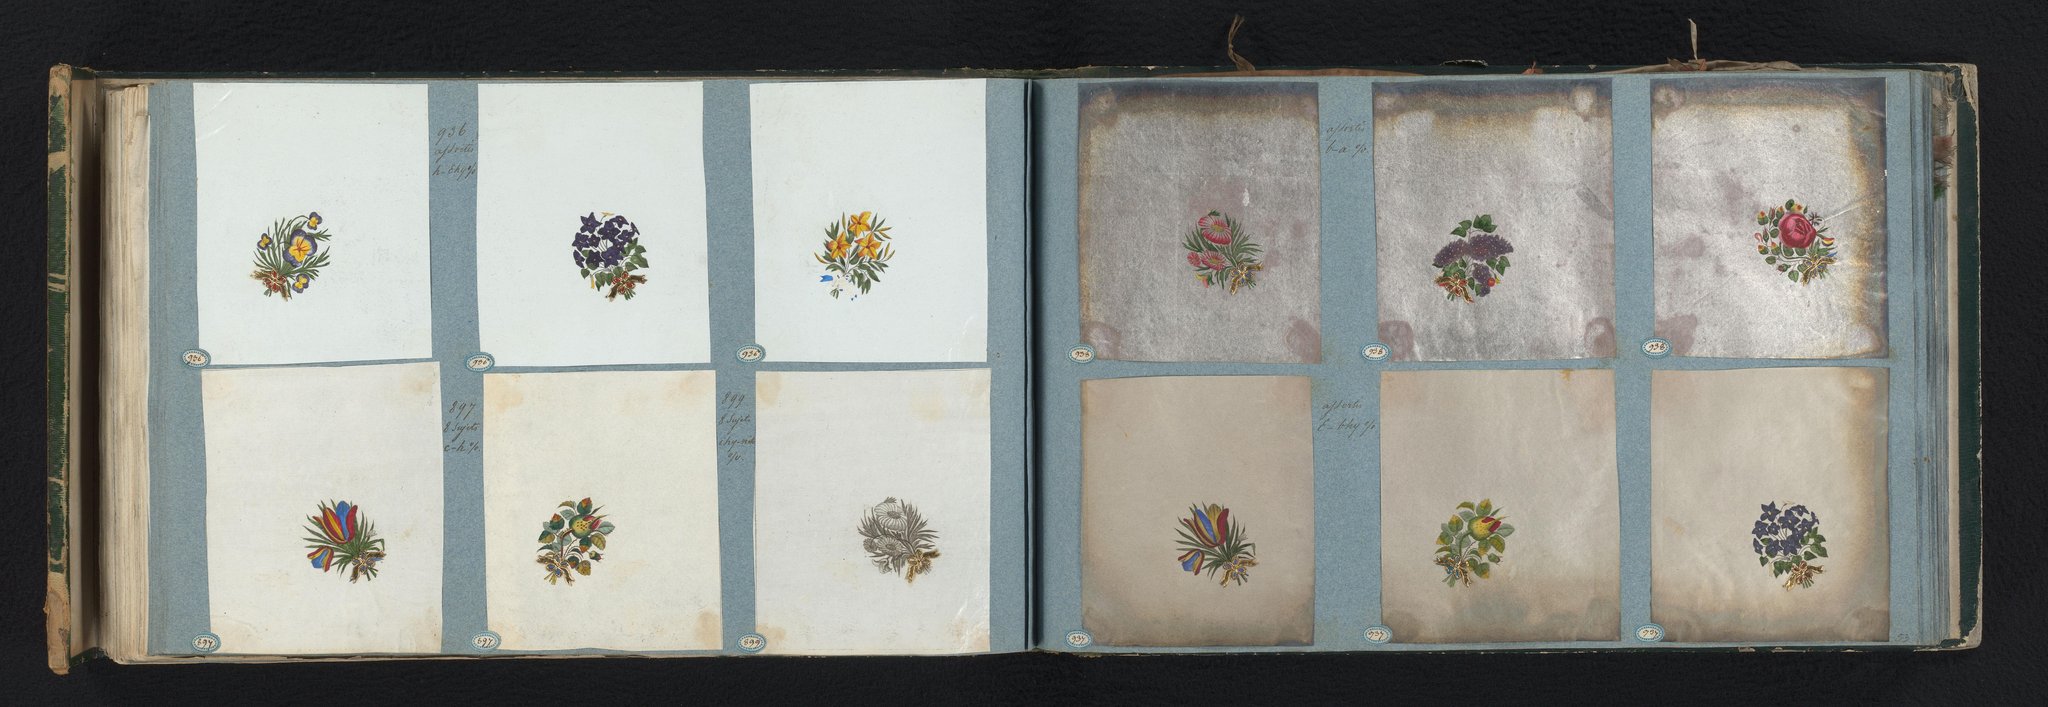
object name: print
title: Twee bladzijden met stalen van boeketten gedrukt op wit en zilverkleurig metaalpapier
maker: Anonymous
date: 1830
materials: gold leaf, ink, paper, watercolor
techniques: manufacturing, etching, hand coloring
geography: france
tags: cut flowers; nosegay, bunch of flowers, ornaments ~ art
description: Twee bladzijden met elk 6 stalen van wit of zilverkleurig papier met gedrukte en met de hand gekleurde bloemstukken versierd met een goudkleurige strik. Alle stalen voorzien van etiketten met nummers (936-937) en handgeschreven codes. Onderdeel van het stalenboek geschonken door de dames Van Rijn, vermoedelijk van een Franse papierfabrikant van luxe papieren, of diens vertegenwoordiger in Nederland, ca. 1830.